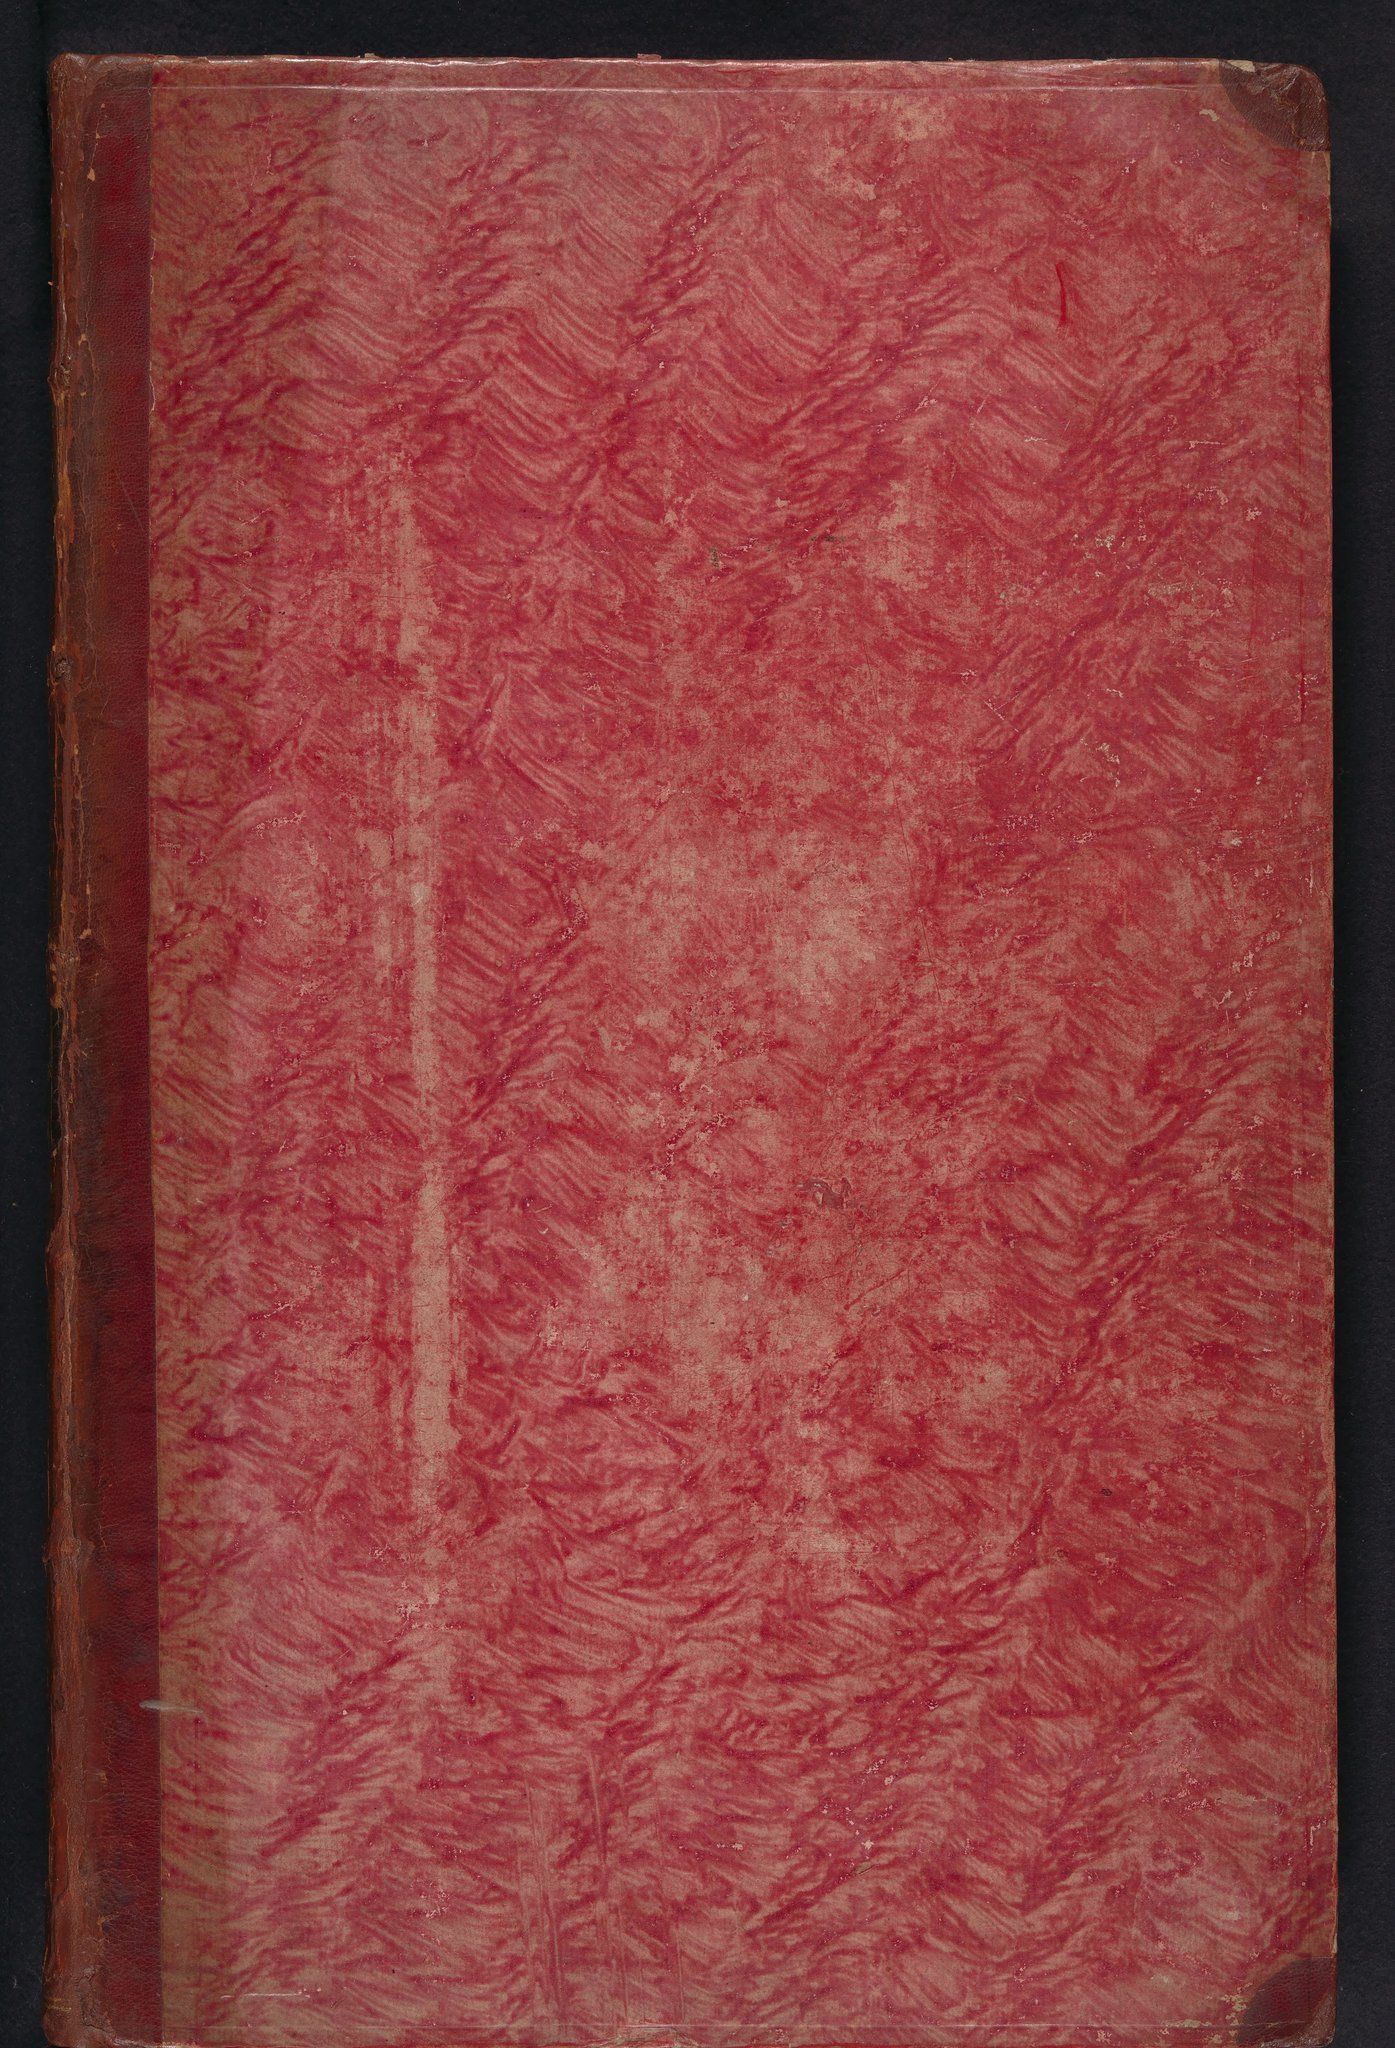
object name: album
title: Historia Naturalis van Rudolf II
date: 1596-1610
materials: leather, paper, watercolor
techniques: bookbinding, brush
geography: delft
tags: vienna, prague, rudolf ii van habsburg (duits keizer)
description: Album met aquarellen van bloemen. Het negende van twaalf albums met aquarellen van dieren, vogels en planten bekend rond 1600, gemaakt in opdracht van keizer Rudolf II. Met toelichting in Nederlands, Latijn en Frans.